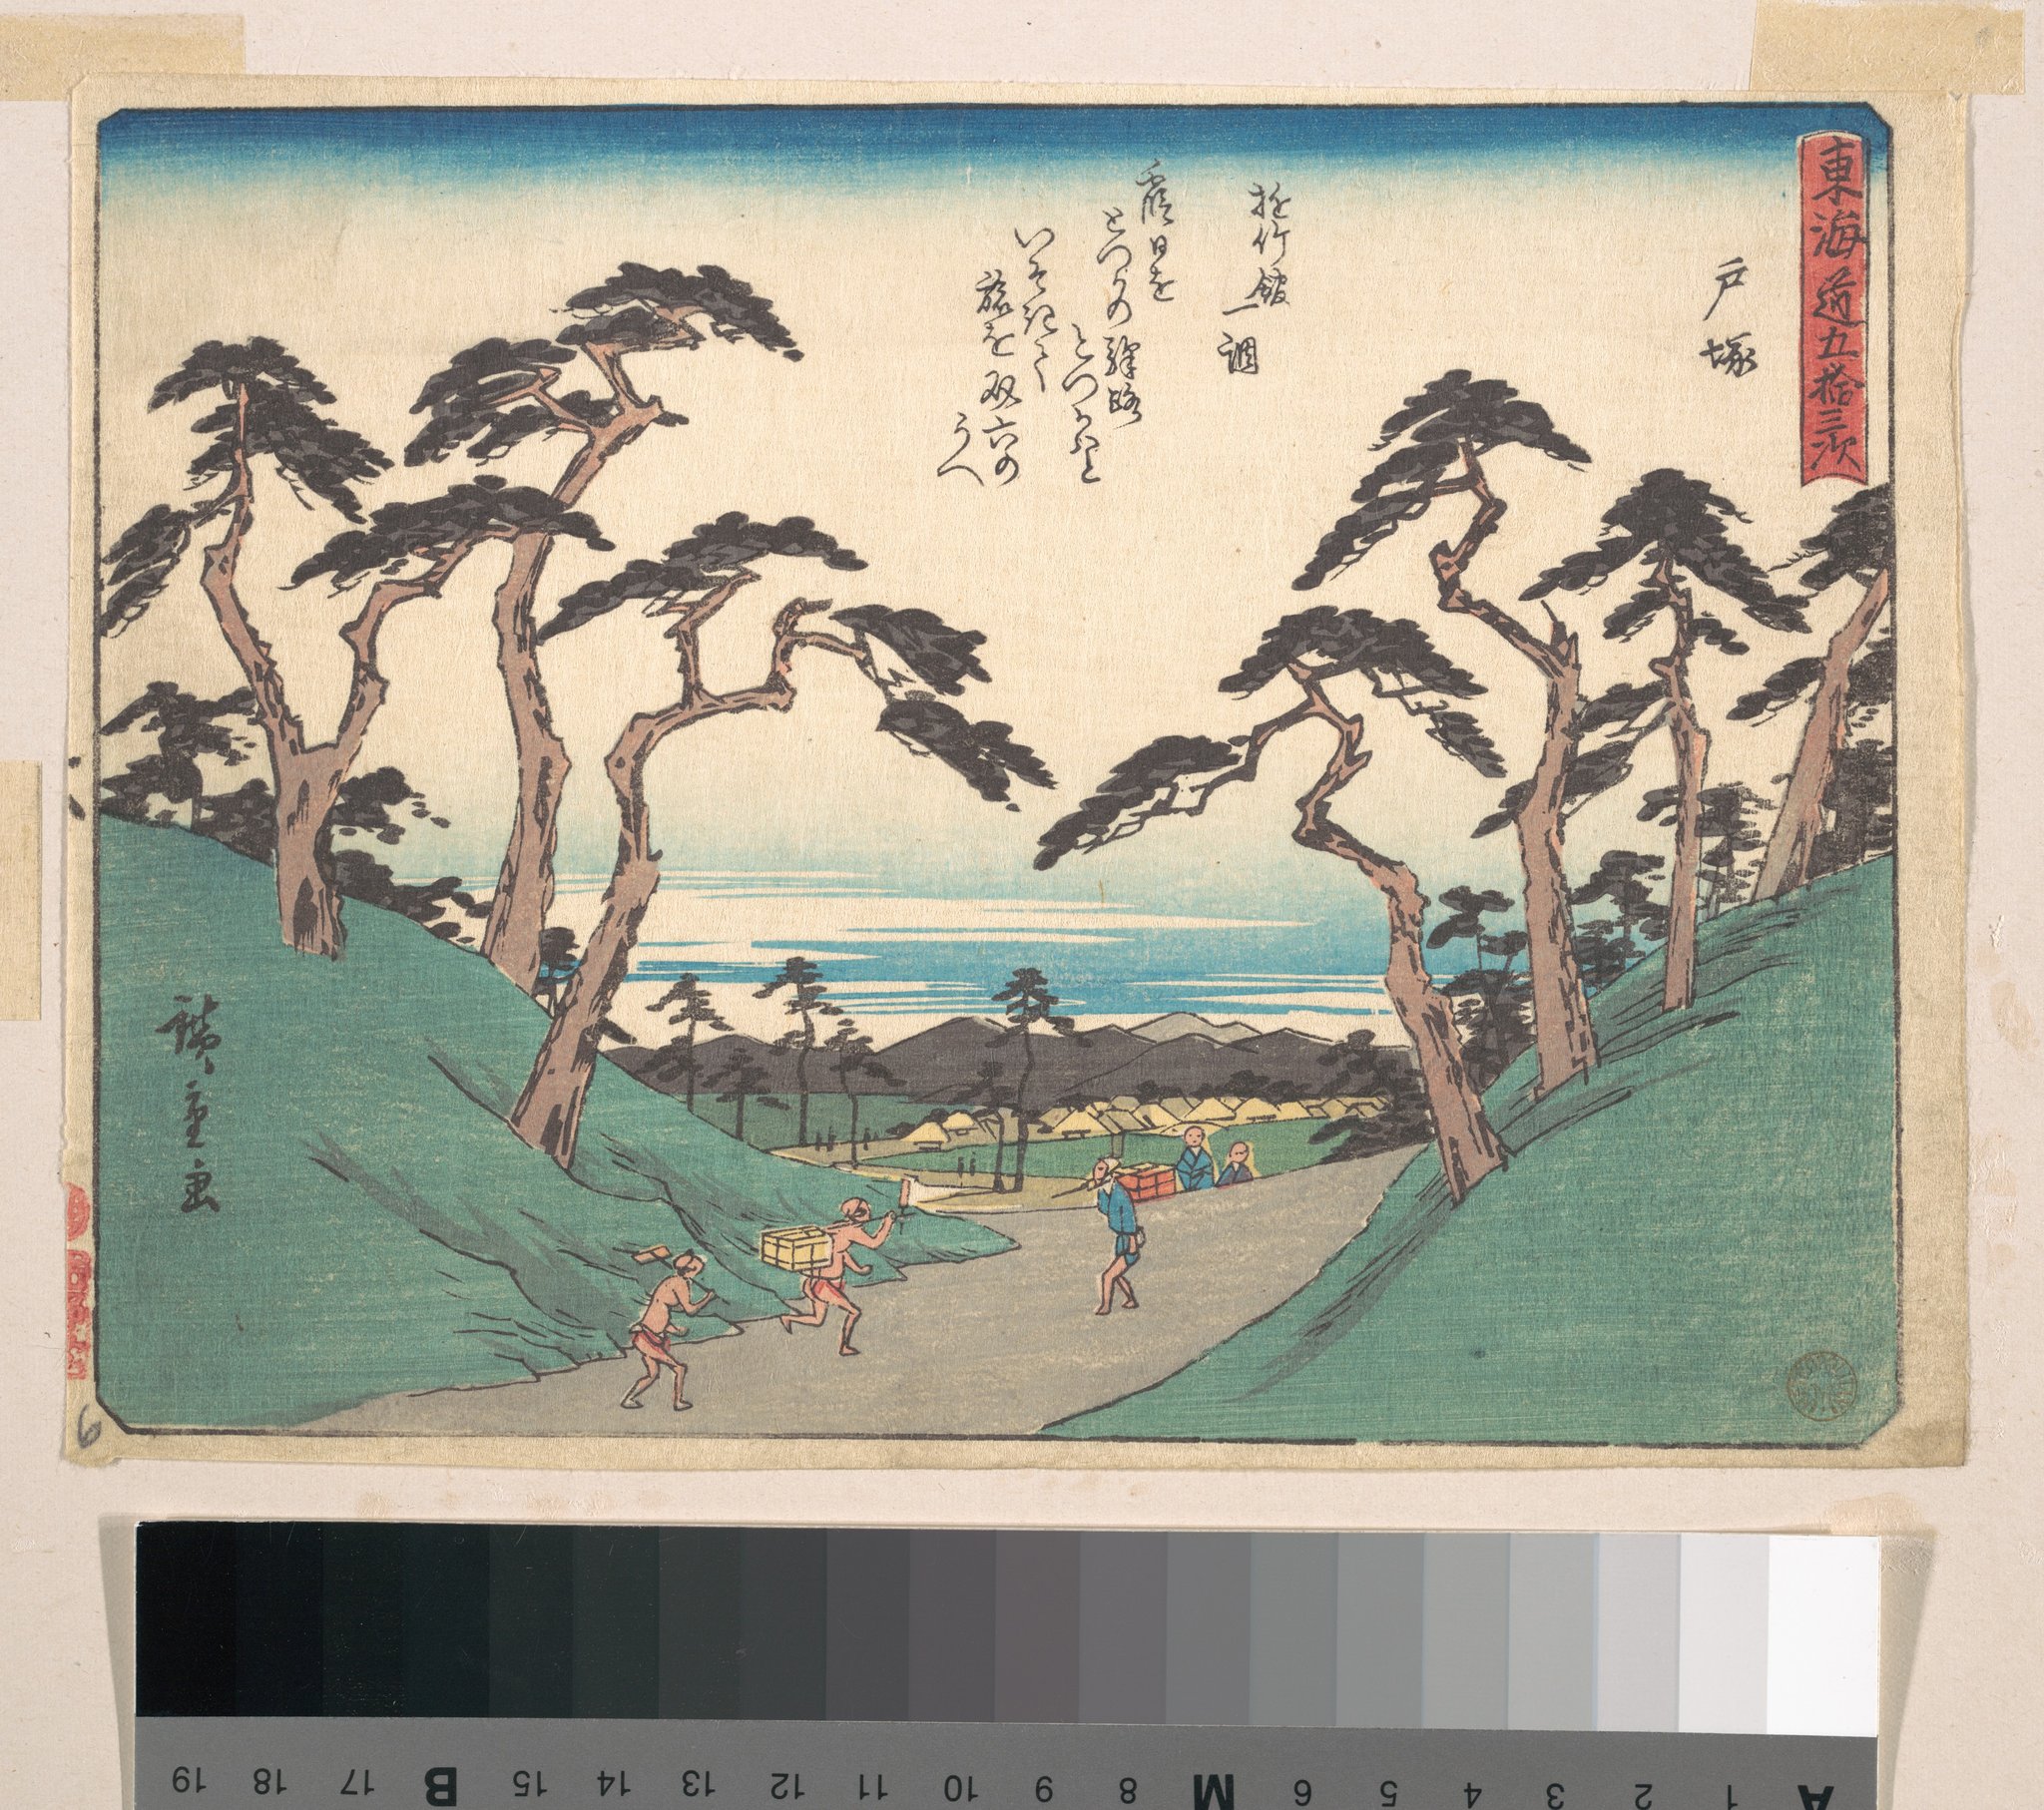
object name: print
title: Totsuka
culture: japanese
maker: utagawa hiroshige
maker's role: artist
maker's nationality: japanese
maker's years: 1797-1858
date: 1838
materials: ink, paper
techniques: woodblock print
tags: hills,landscapes,trees